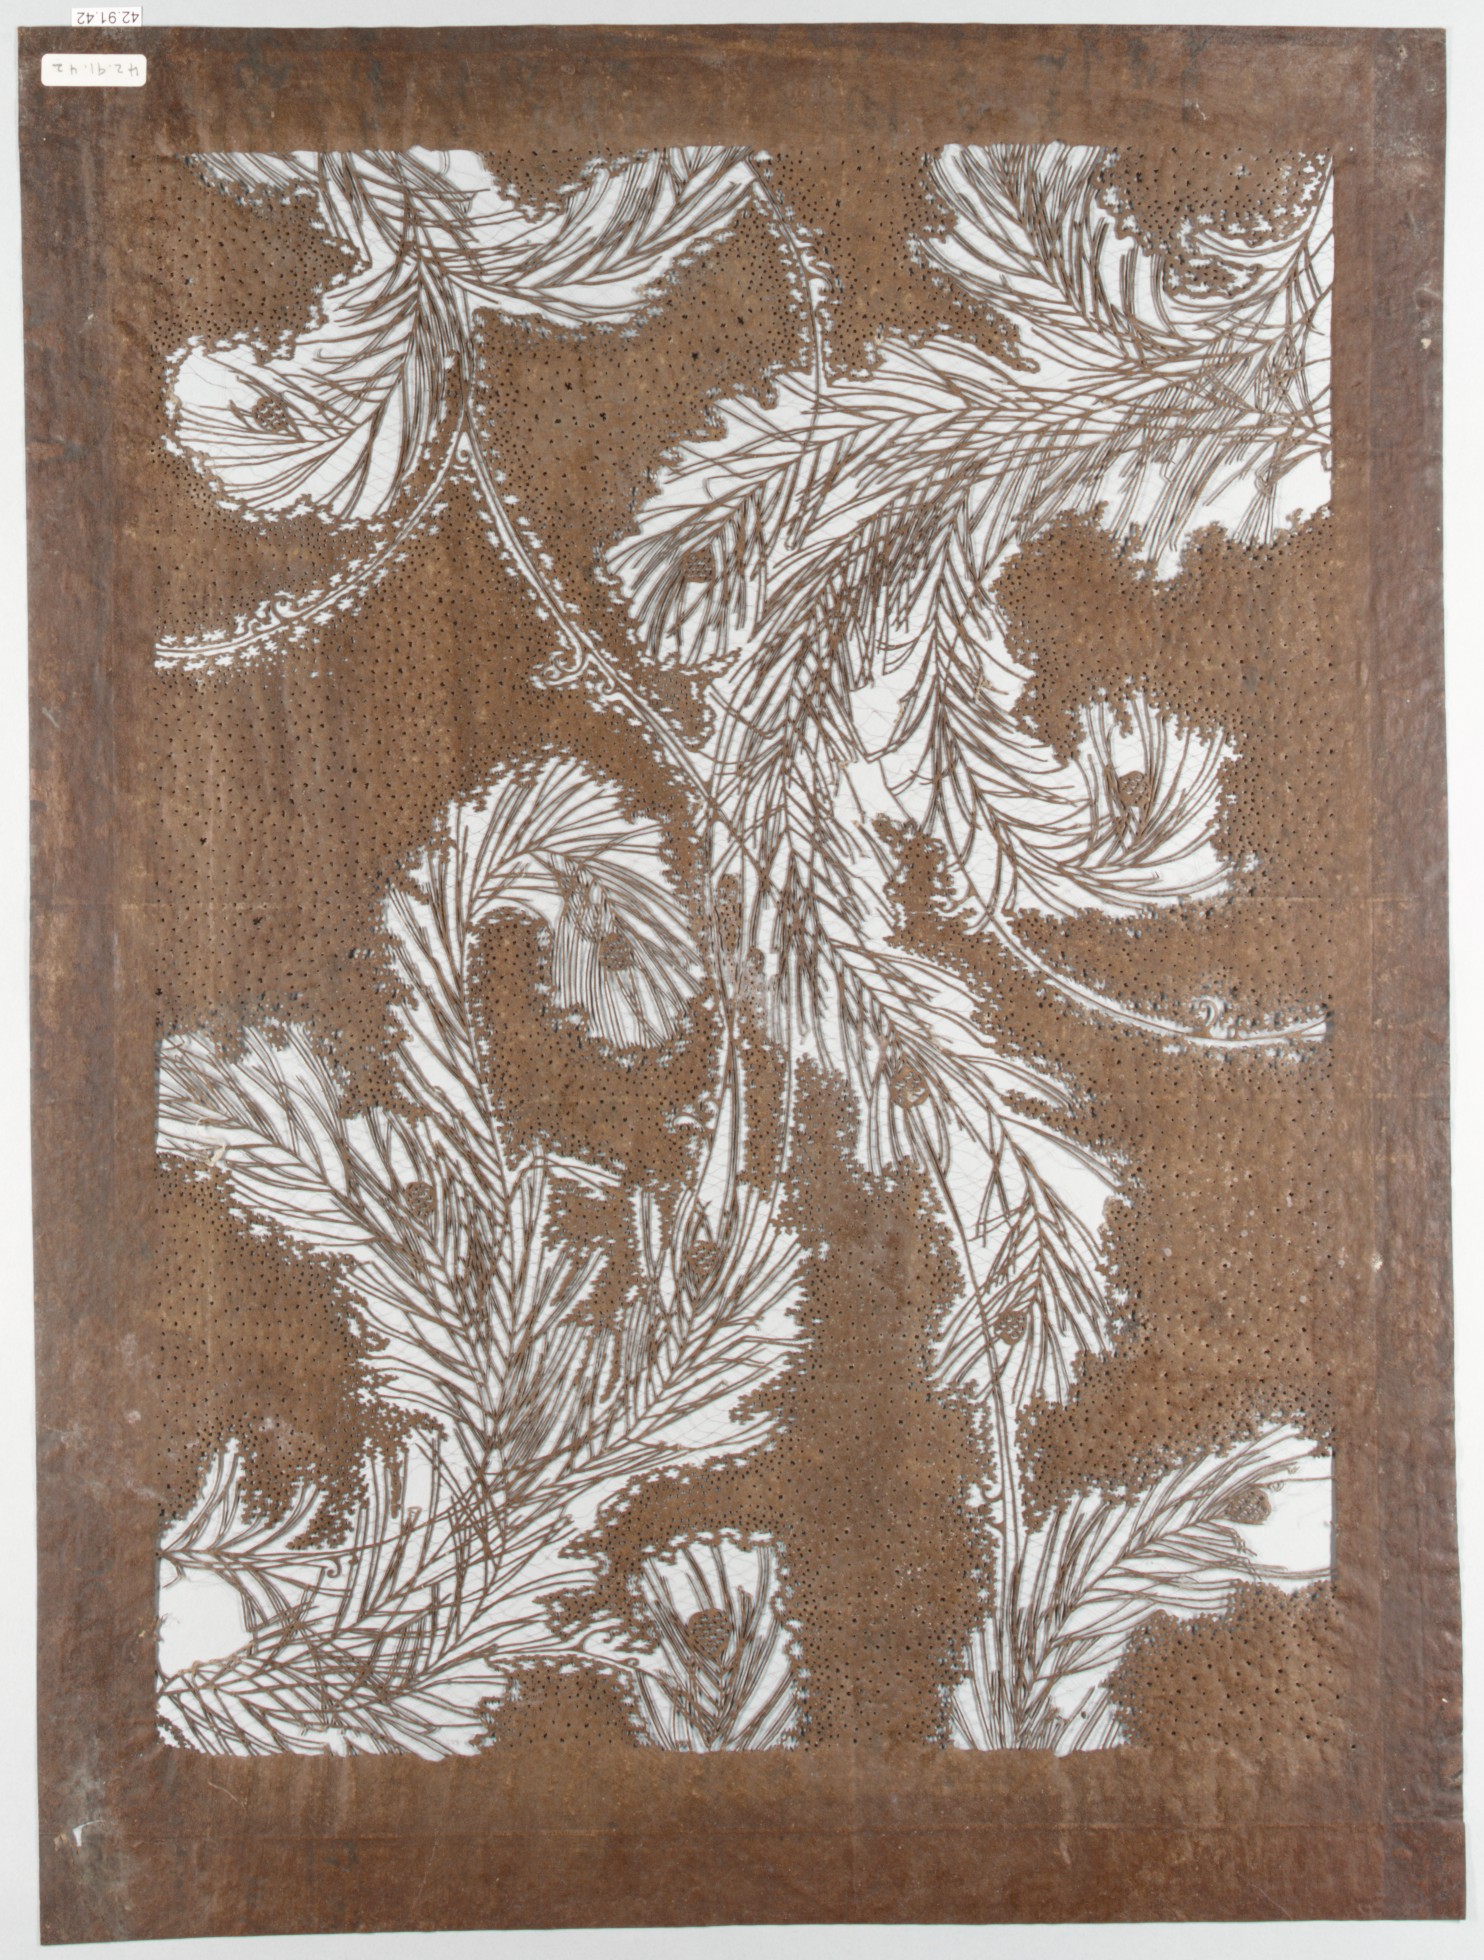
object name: stencil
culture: japanese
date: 1801-1900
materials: paper, silk